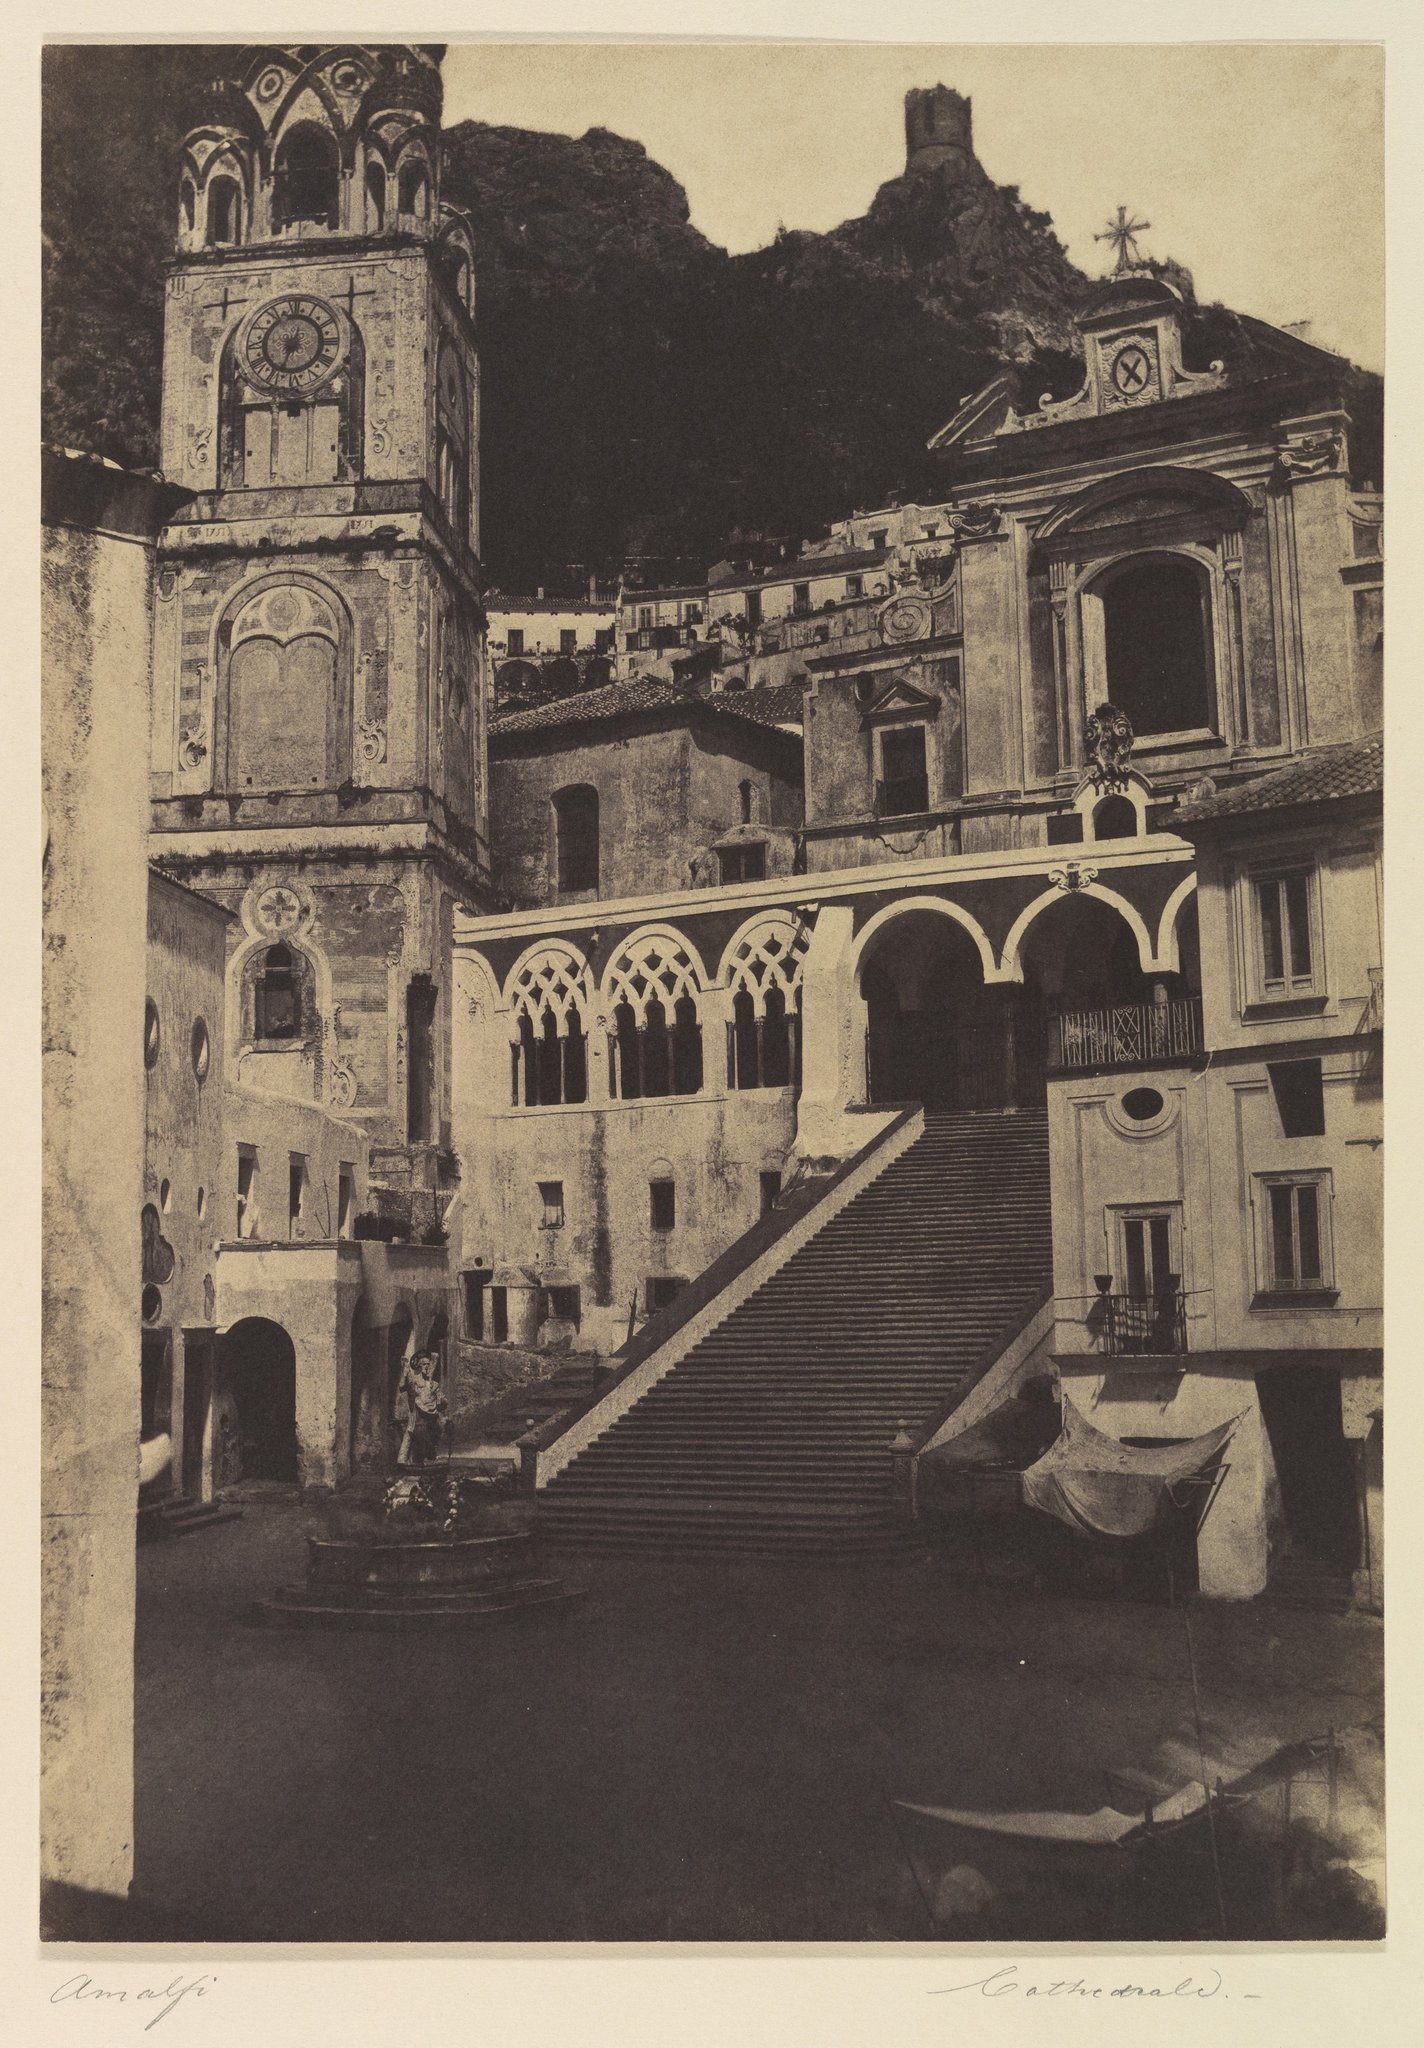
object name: photograph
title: Amalfi, Cathedral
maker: firmin-eugène le dien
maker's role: artist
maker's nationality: french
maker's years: 1817-1865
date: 1853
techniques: paper negative, salted paper print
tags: architecture,cathedrals